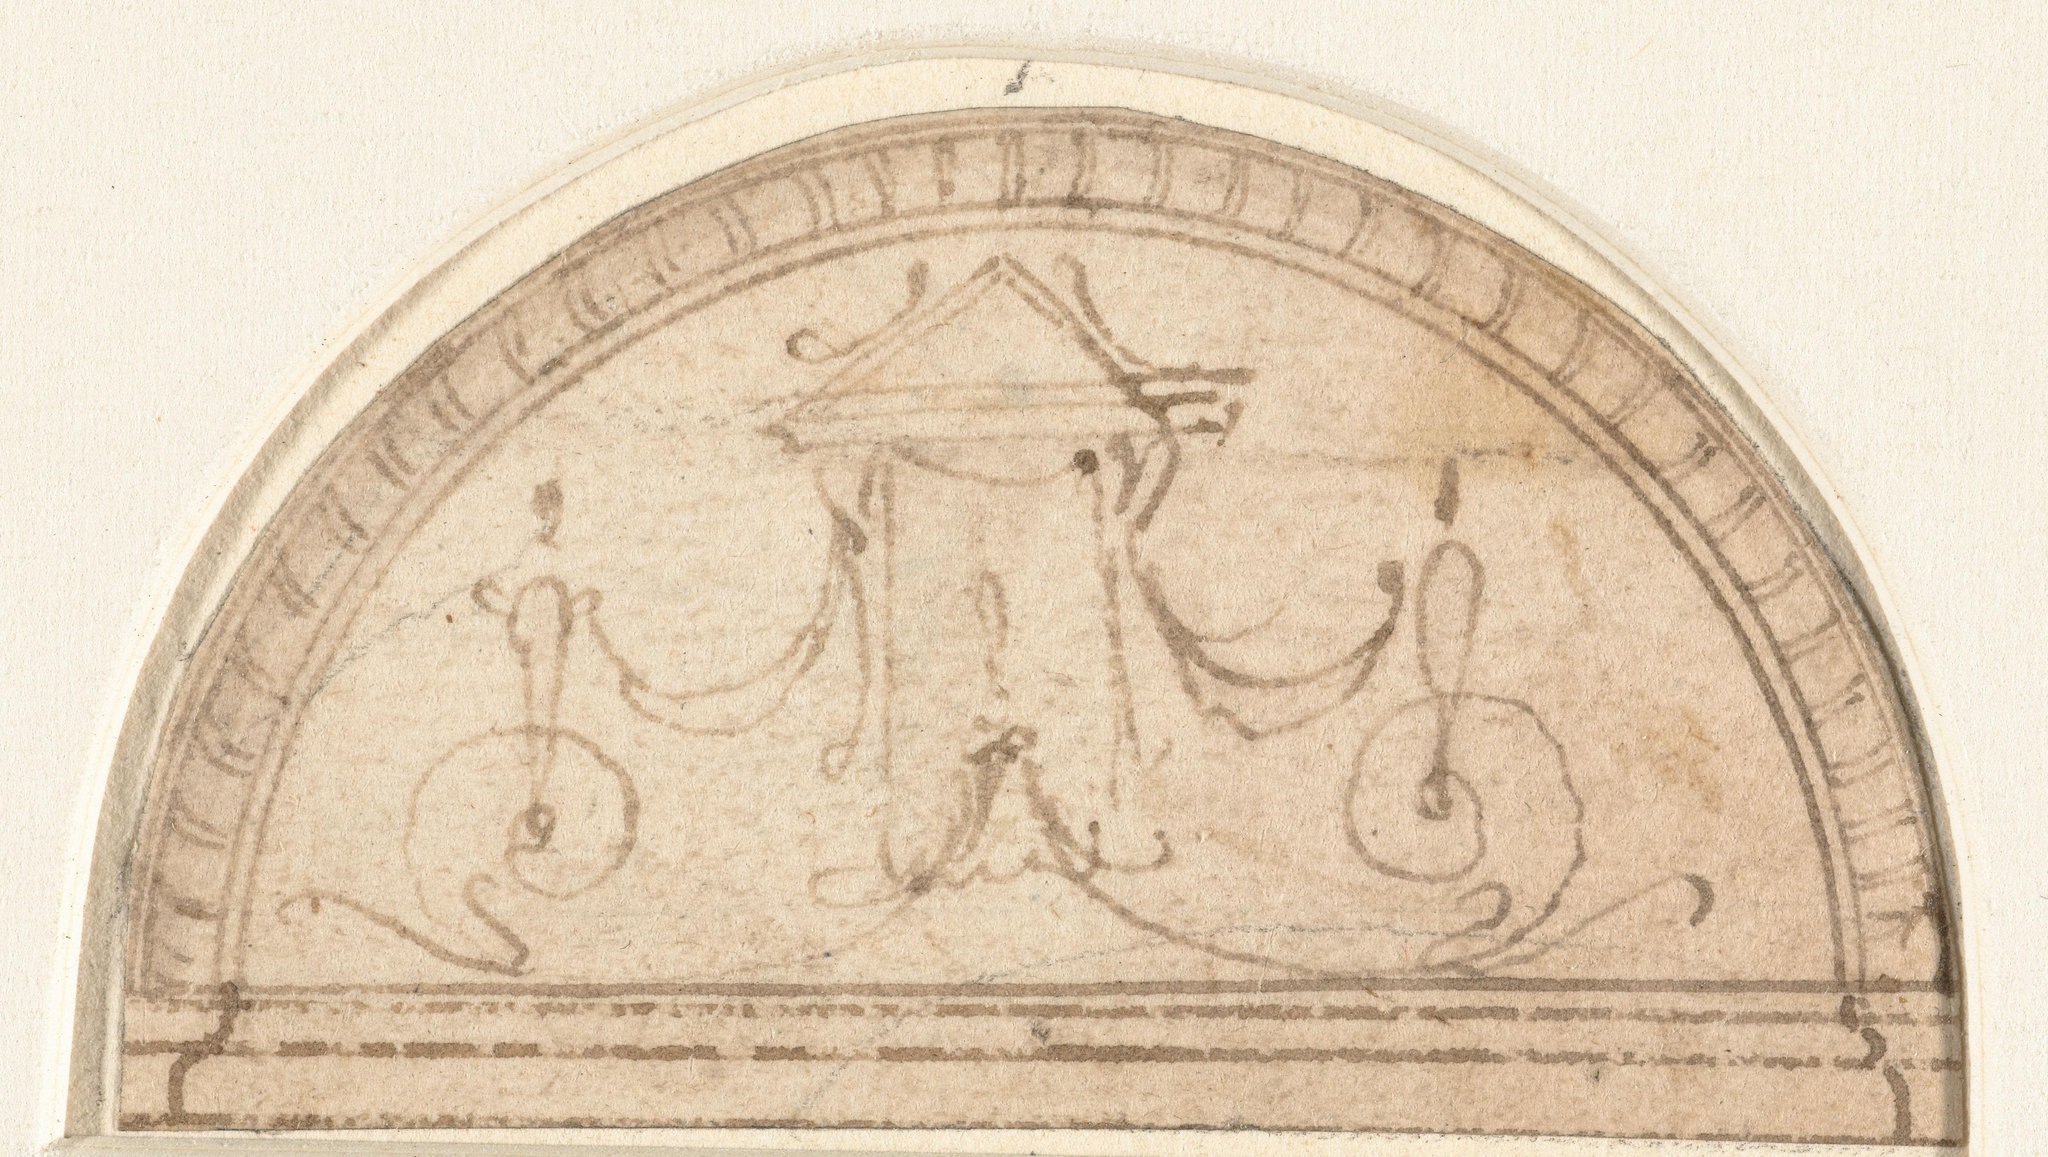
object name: drawing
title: Ornament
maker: perino del vaga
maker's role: draughtsman, painter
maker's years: 1501-1547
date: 1520-1547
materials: ink, paper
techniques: pen